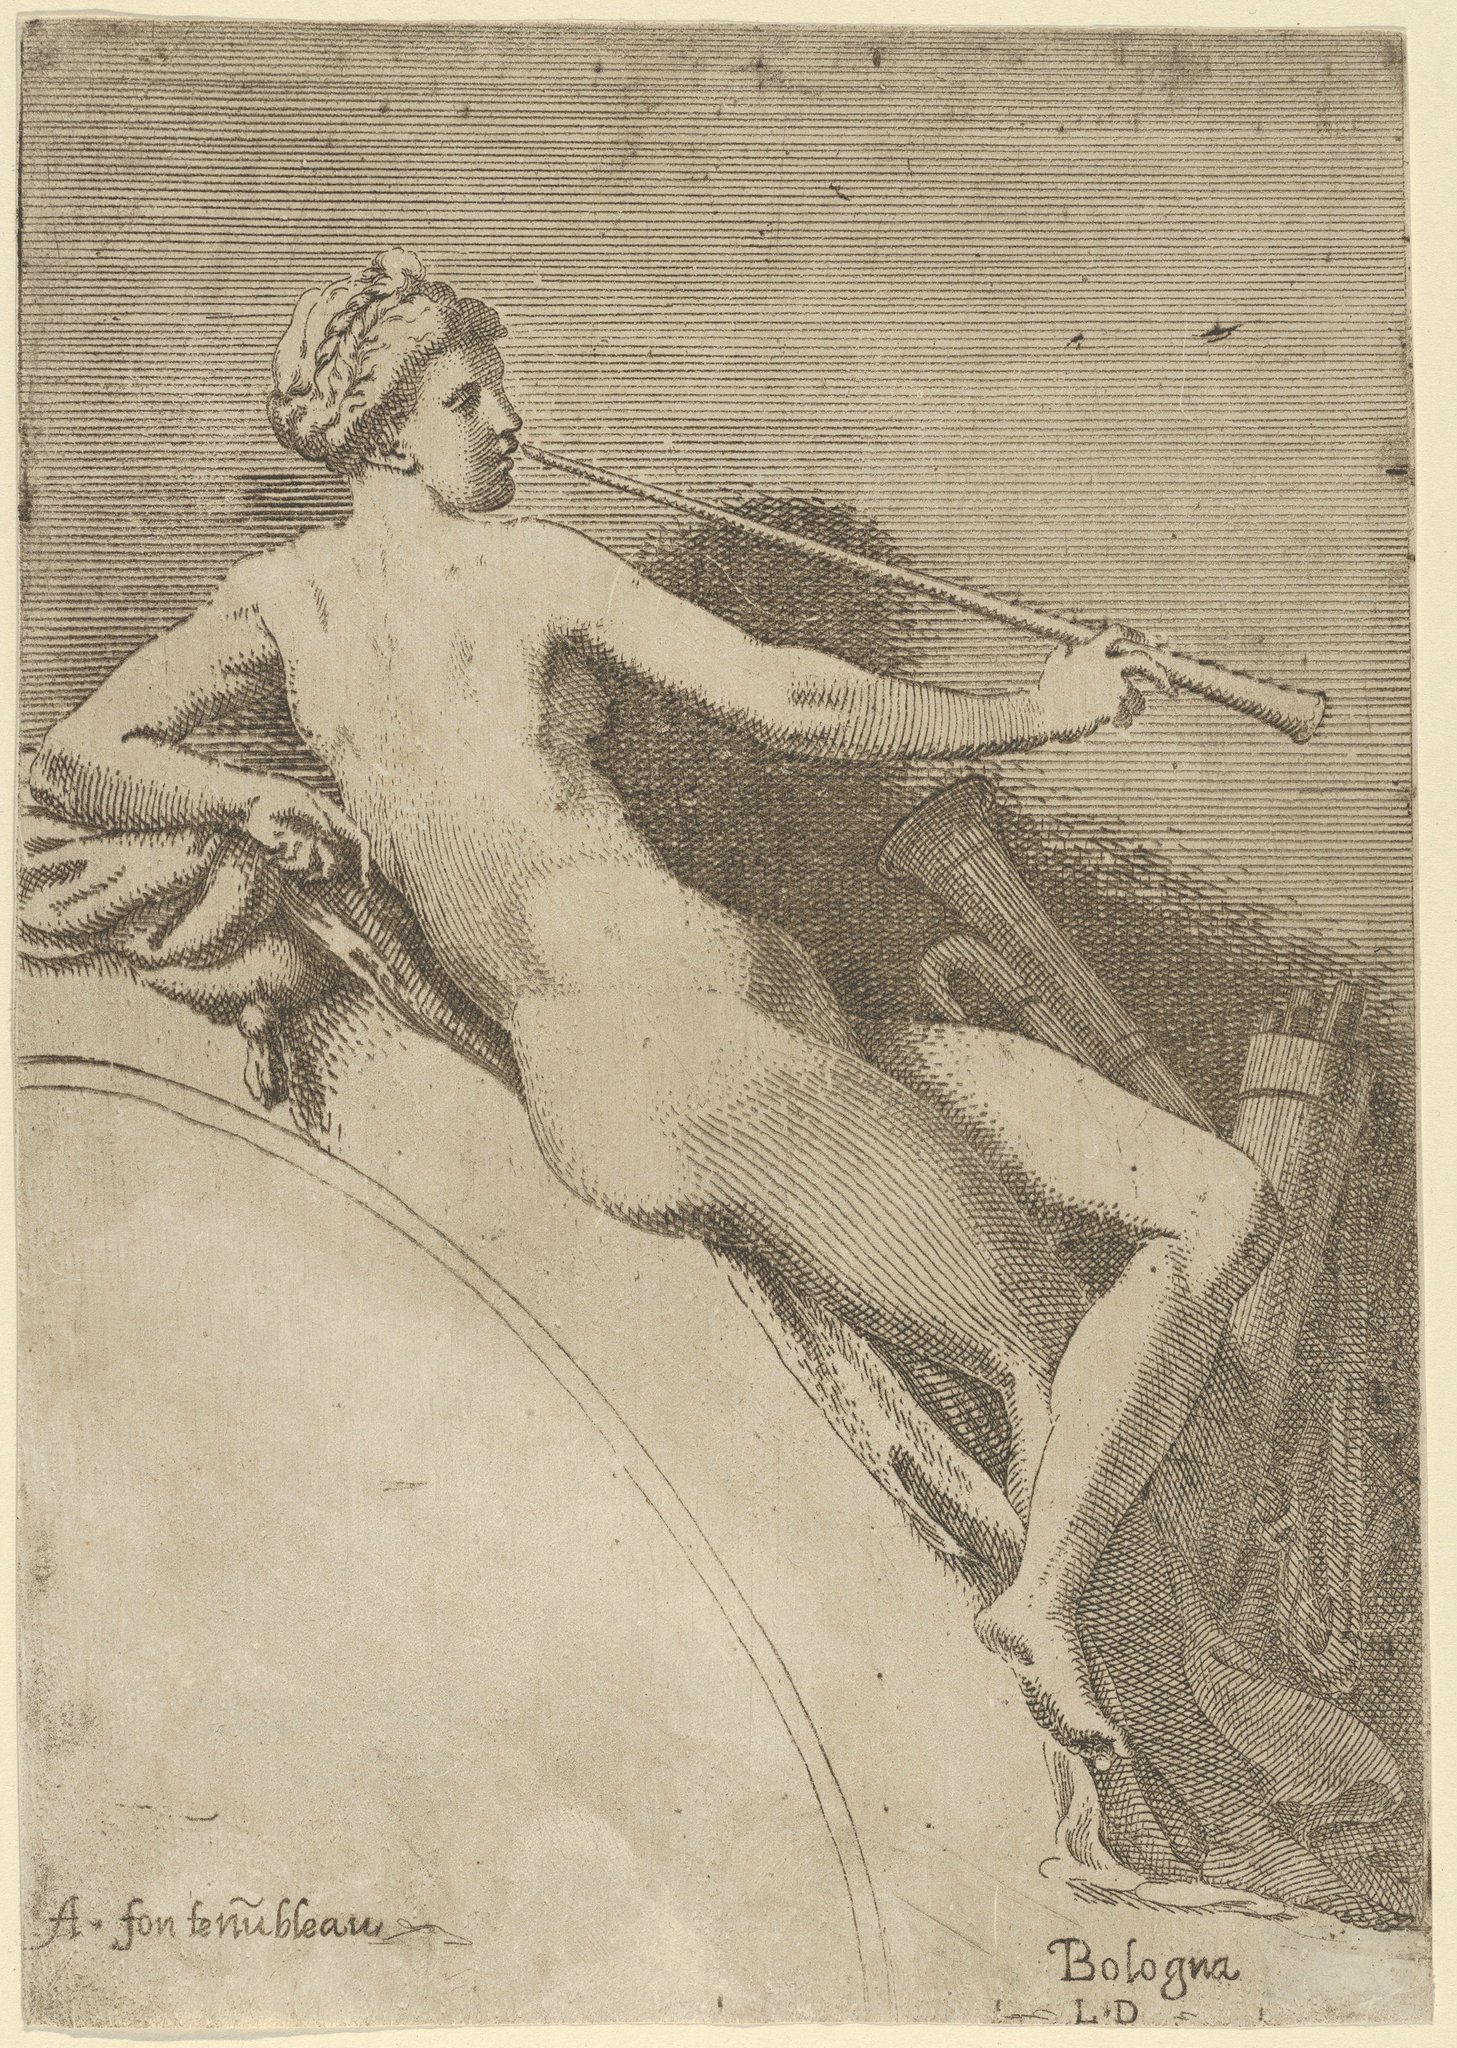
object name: print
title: Euterpe, from "Twelve Muses and Goddesses"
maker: léon davent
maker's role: artist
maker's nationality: french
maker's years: 1540-1556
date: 1540-1545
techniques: etching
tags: musical instruments,muses